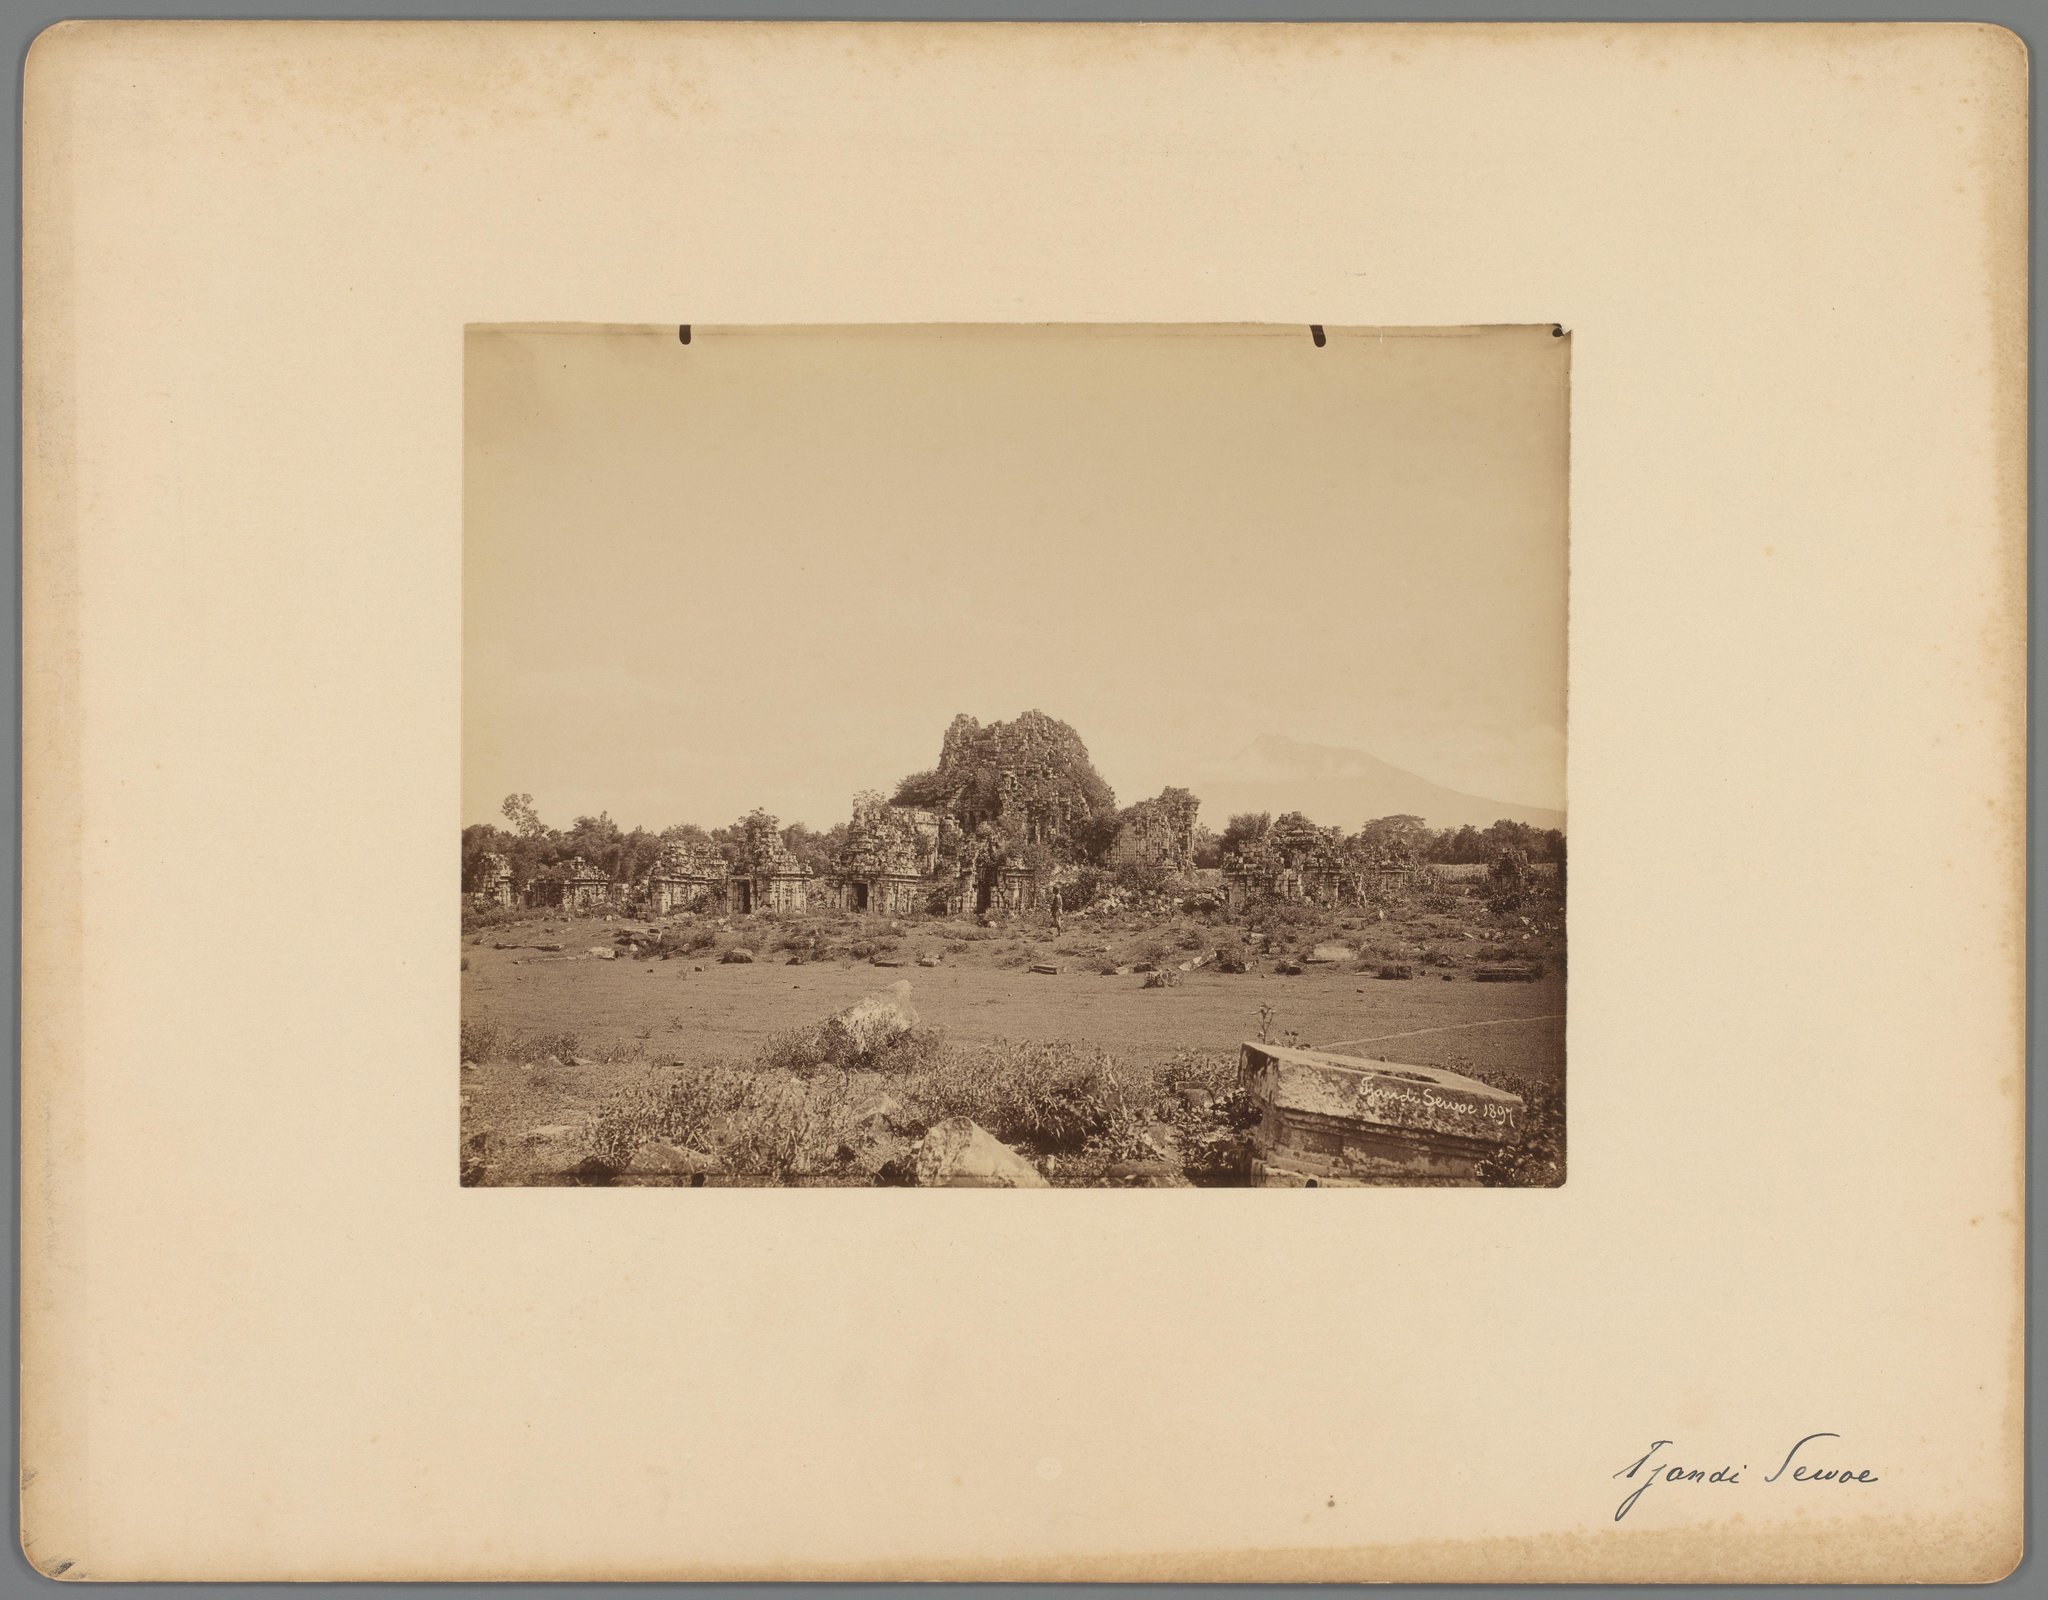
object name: photograph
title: Tjandi Sewoe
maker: kassian céphas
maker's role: fotograaf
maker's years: 1845-1912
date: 1897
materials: cardboard, paper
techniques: albumen print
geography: central java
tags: landscape with ruins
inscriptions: inscription: ‘Tjandi Sewoe 1897’, inscription: ‘Foto’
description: Deze foto zat oorspronkelijk in prentenkabinet RP-F-AA3192.